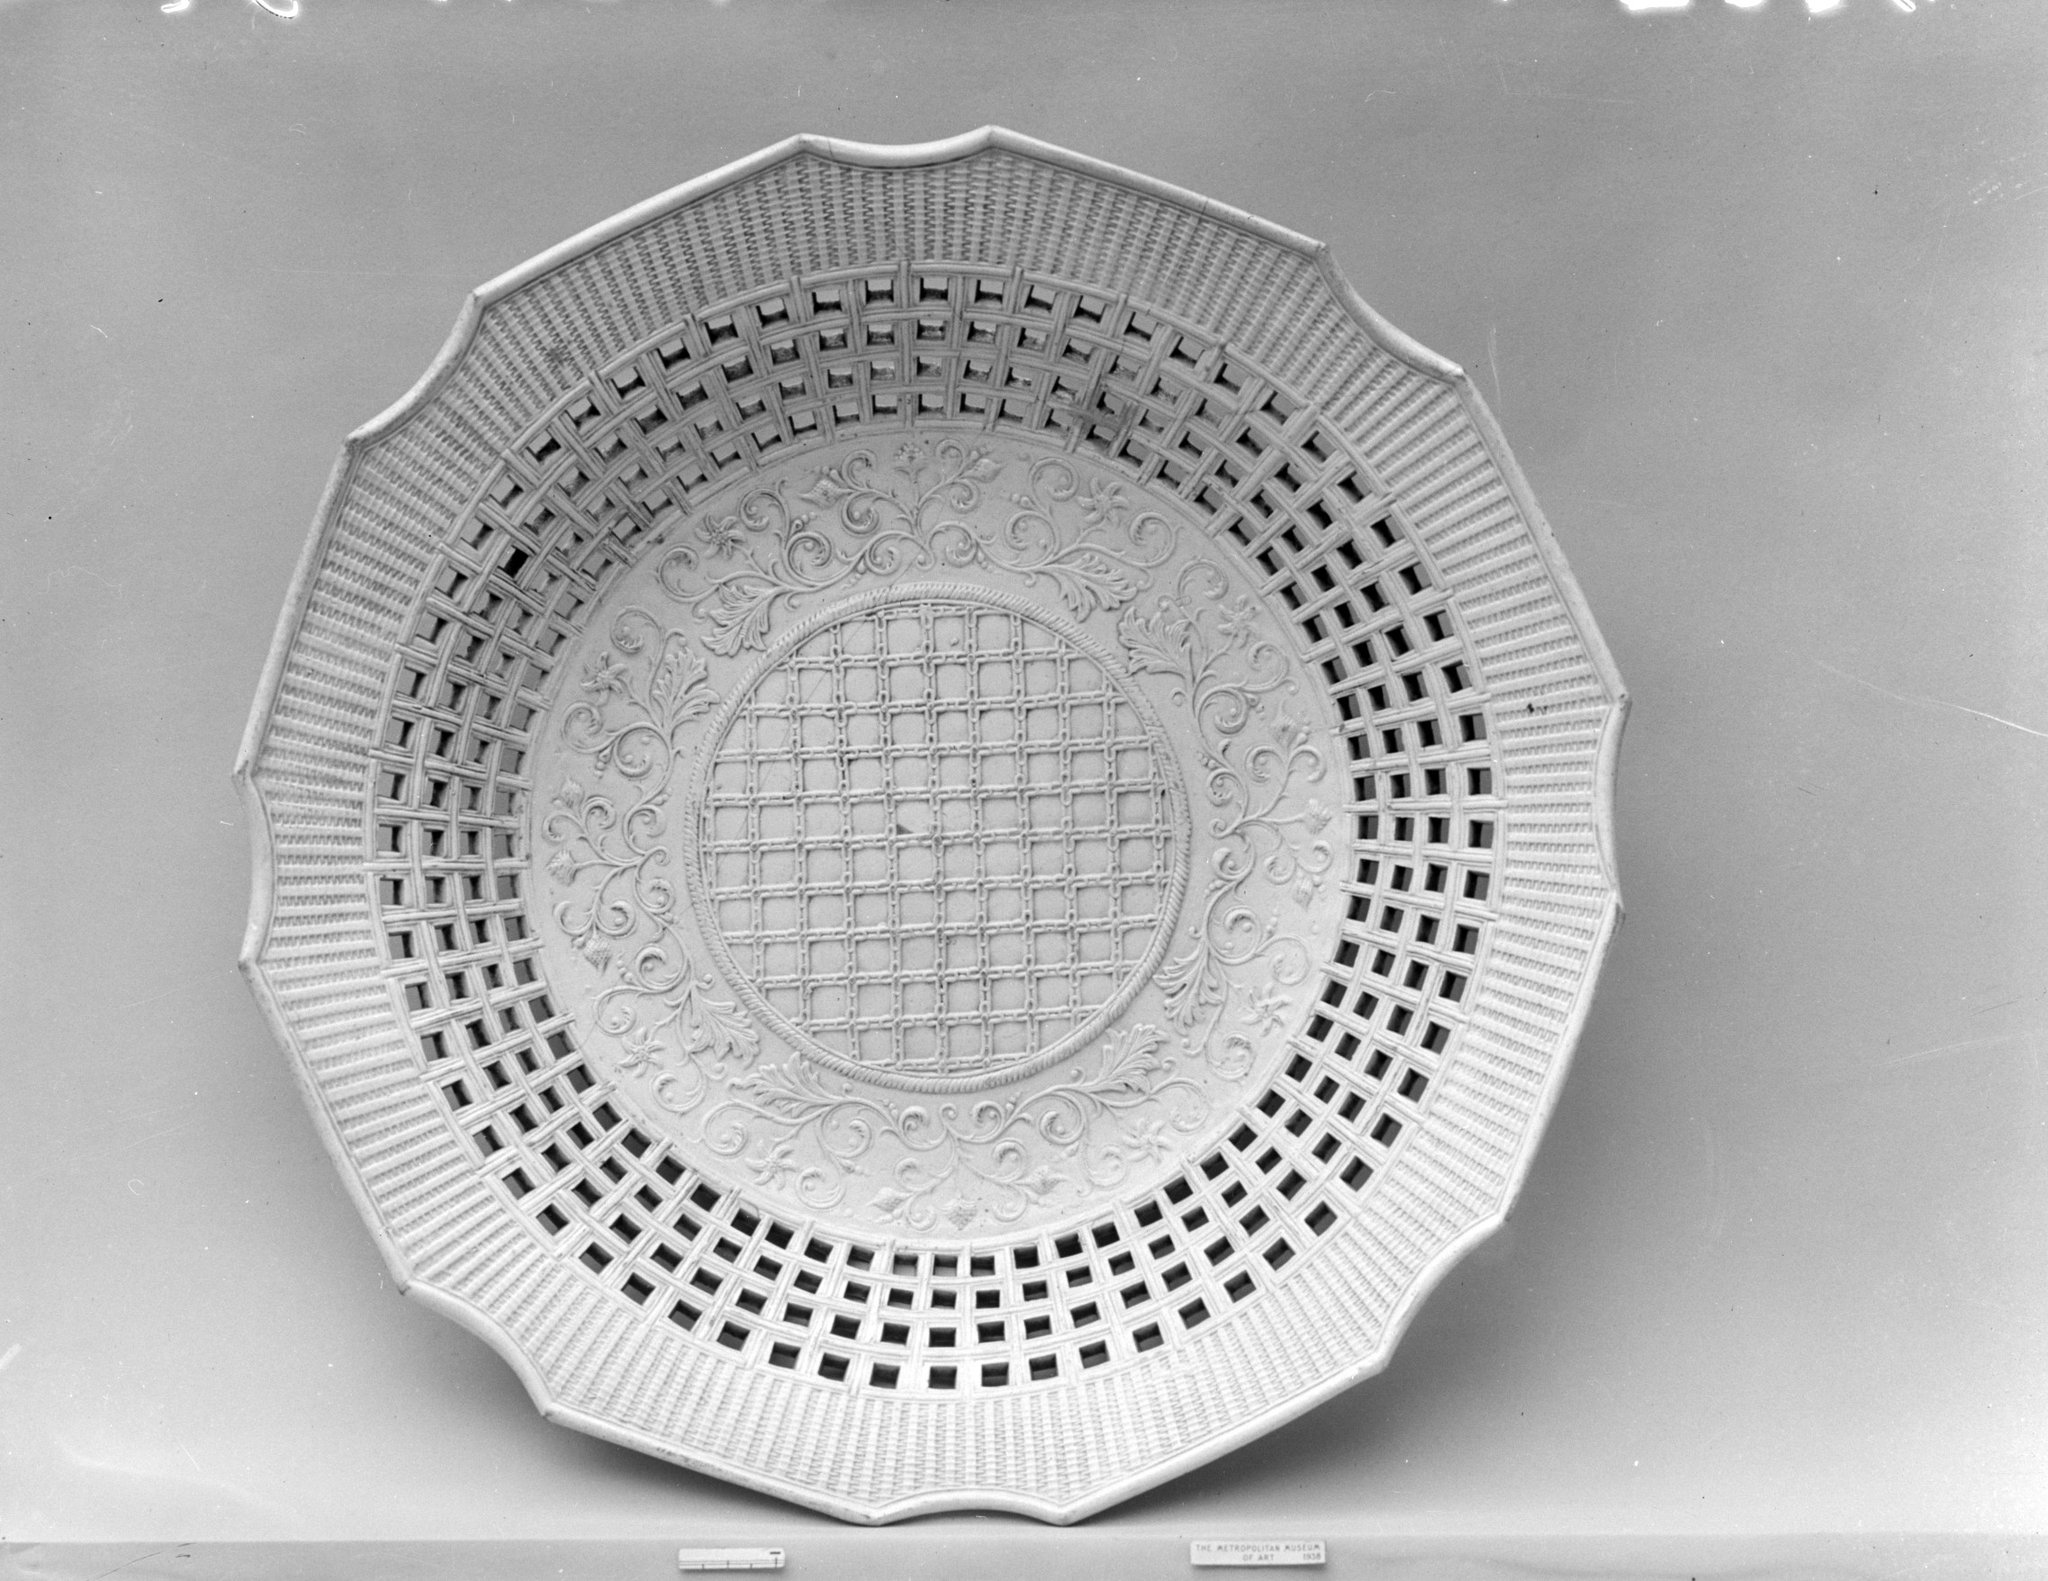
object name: dish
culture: british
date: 1770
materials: stoneware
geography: england